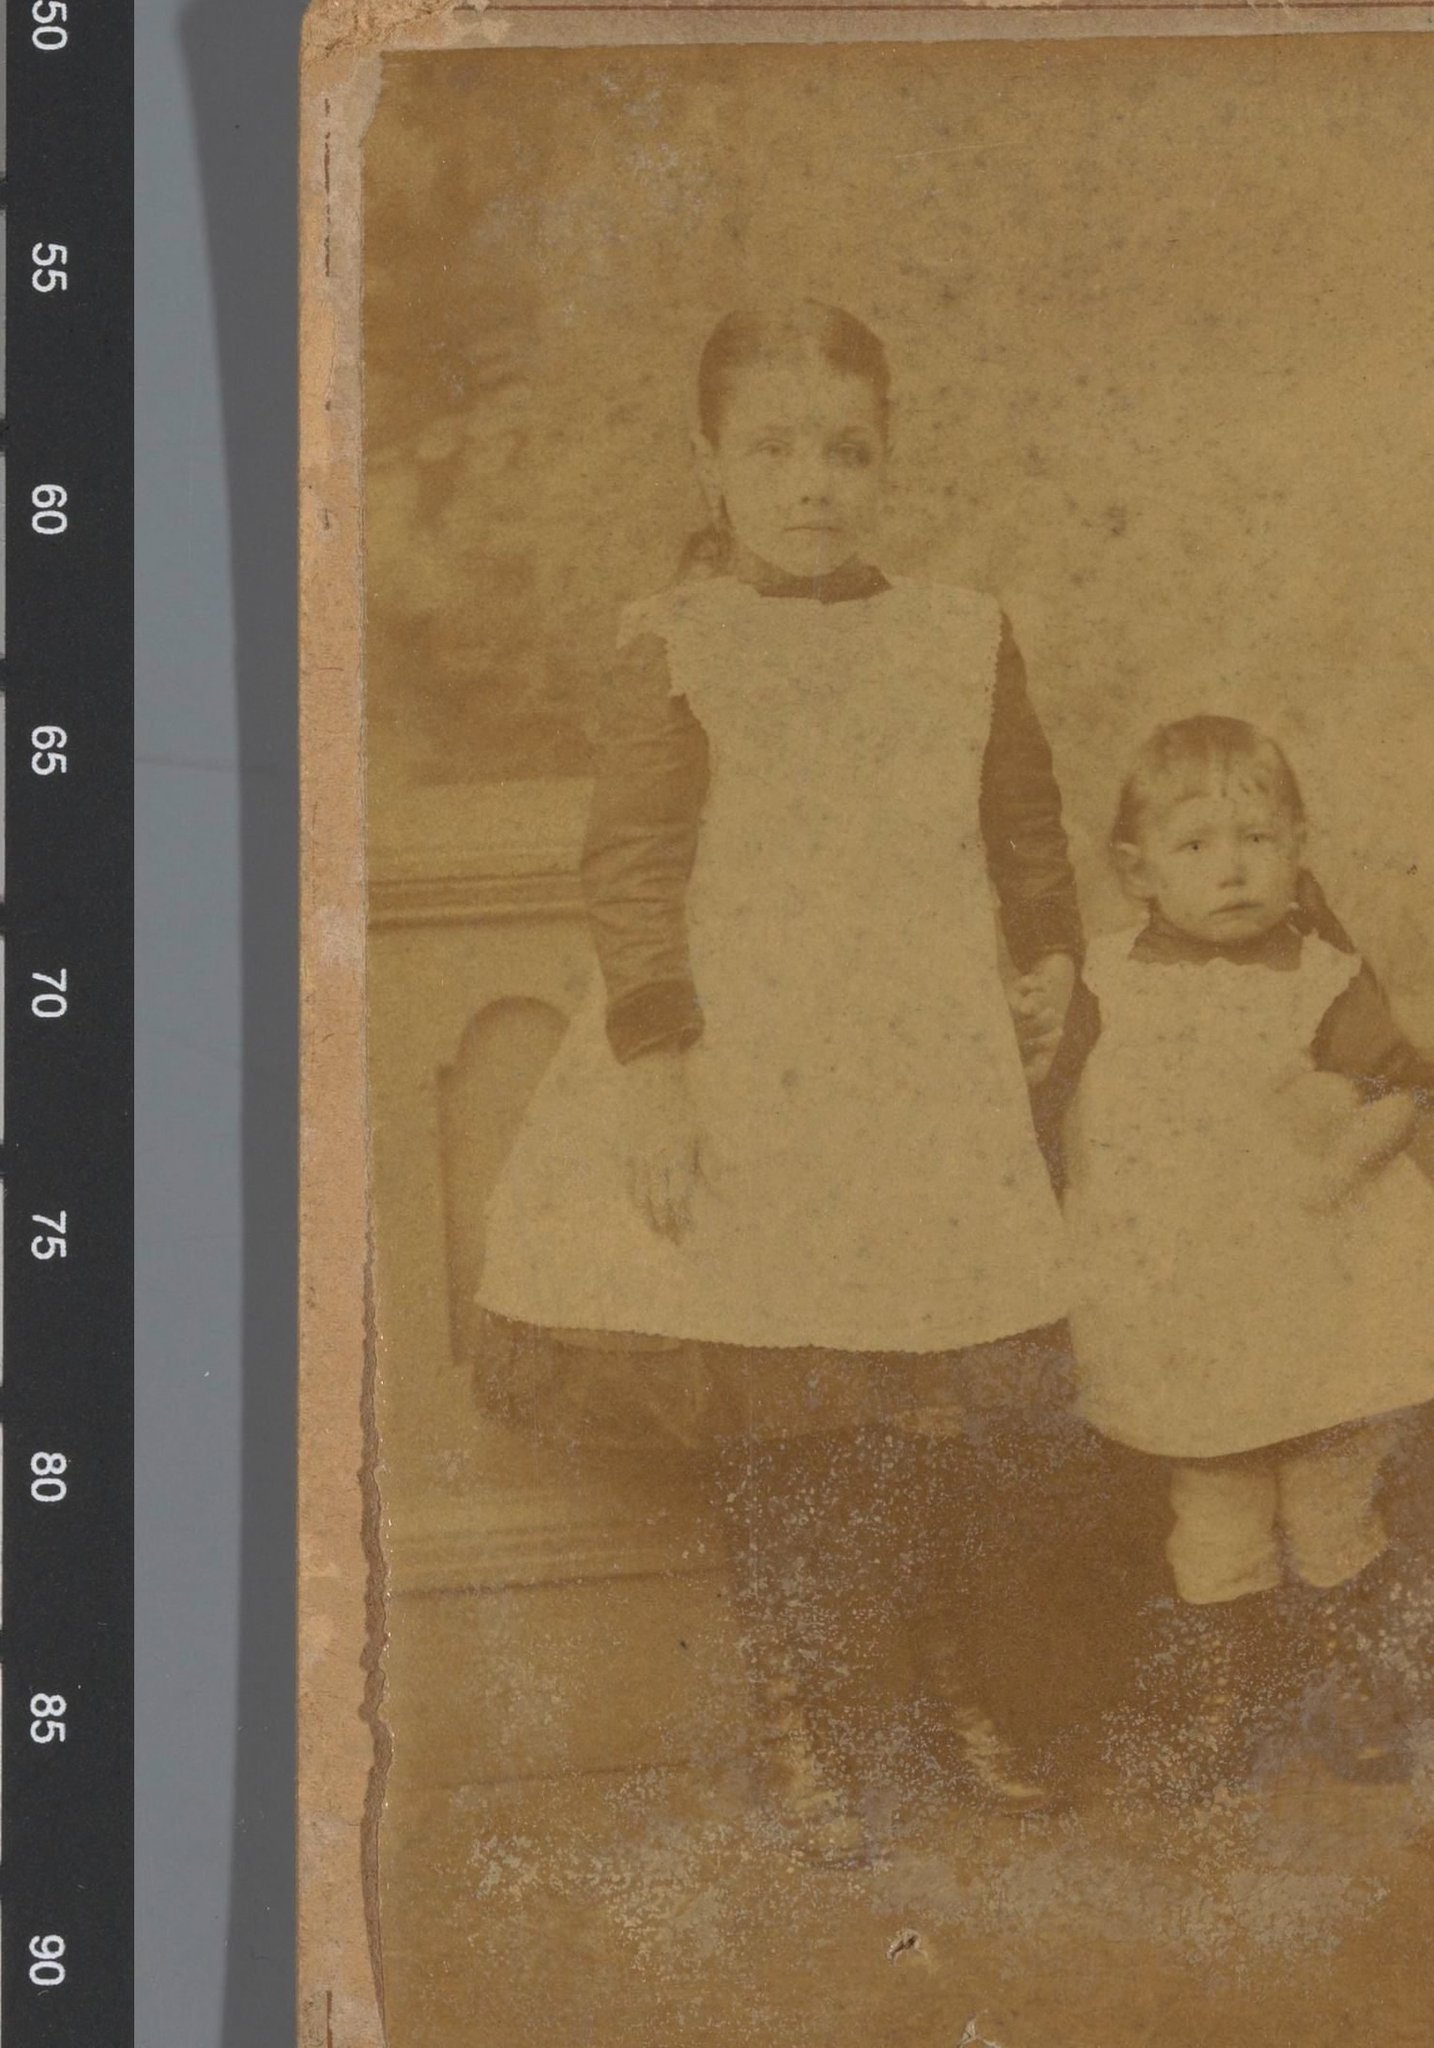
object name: photograph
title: Portret van twee onbekende kinderen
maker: pieter siewers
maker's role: fotograaf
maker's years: 1819-1898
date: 1857-1898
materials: cardboard, paper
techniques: albumen print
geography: edam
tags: historical persons, child (+ two persons)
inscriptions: stamp: ‘P. SIEWERS/ PHOTOGRAAF/ EDAM.’